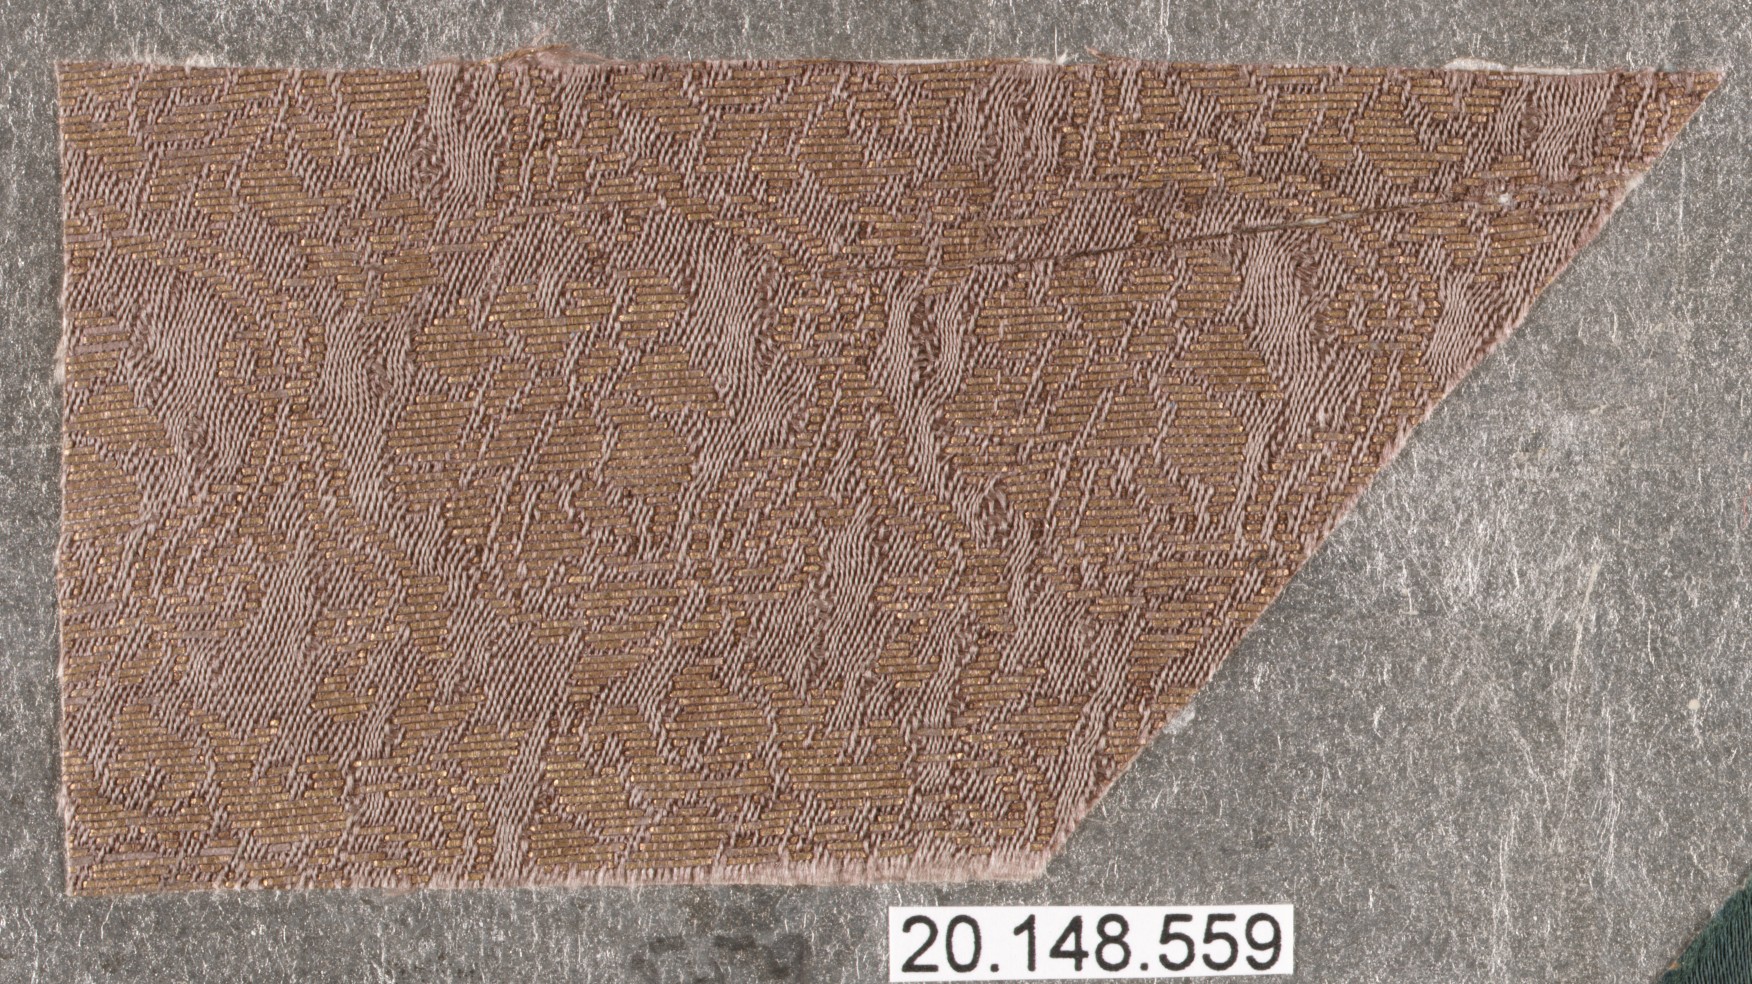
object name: piece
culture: japanese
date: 1701-1800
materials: silk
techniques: compound weave